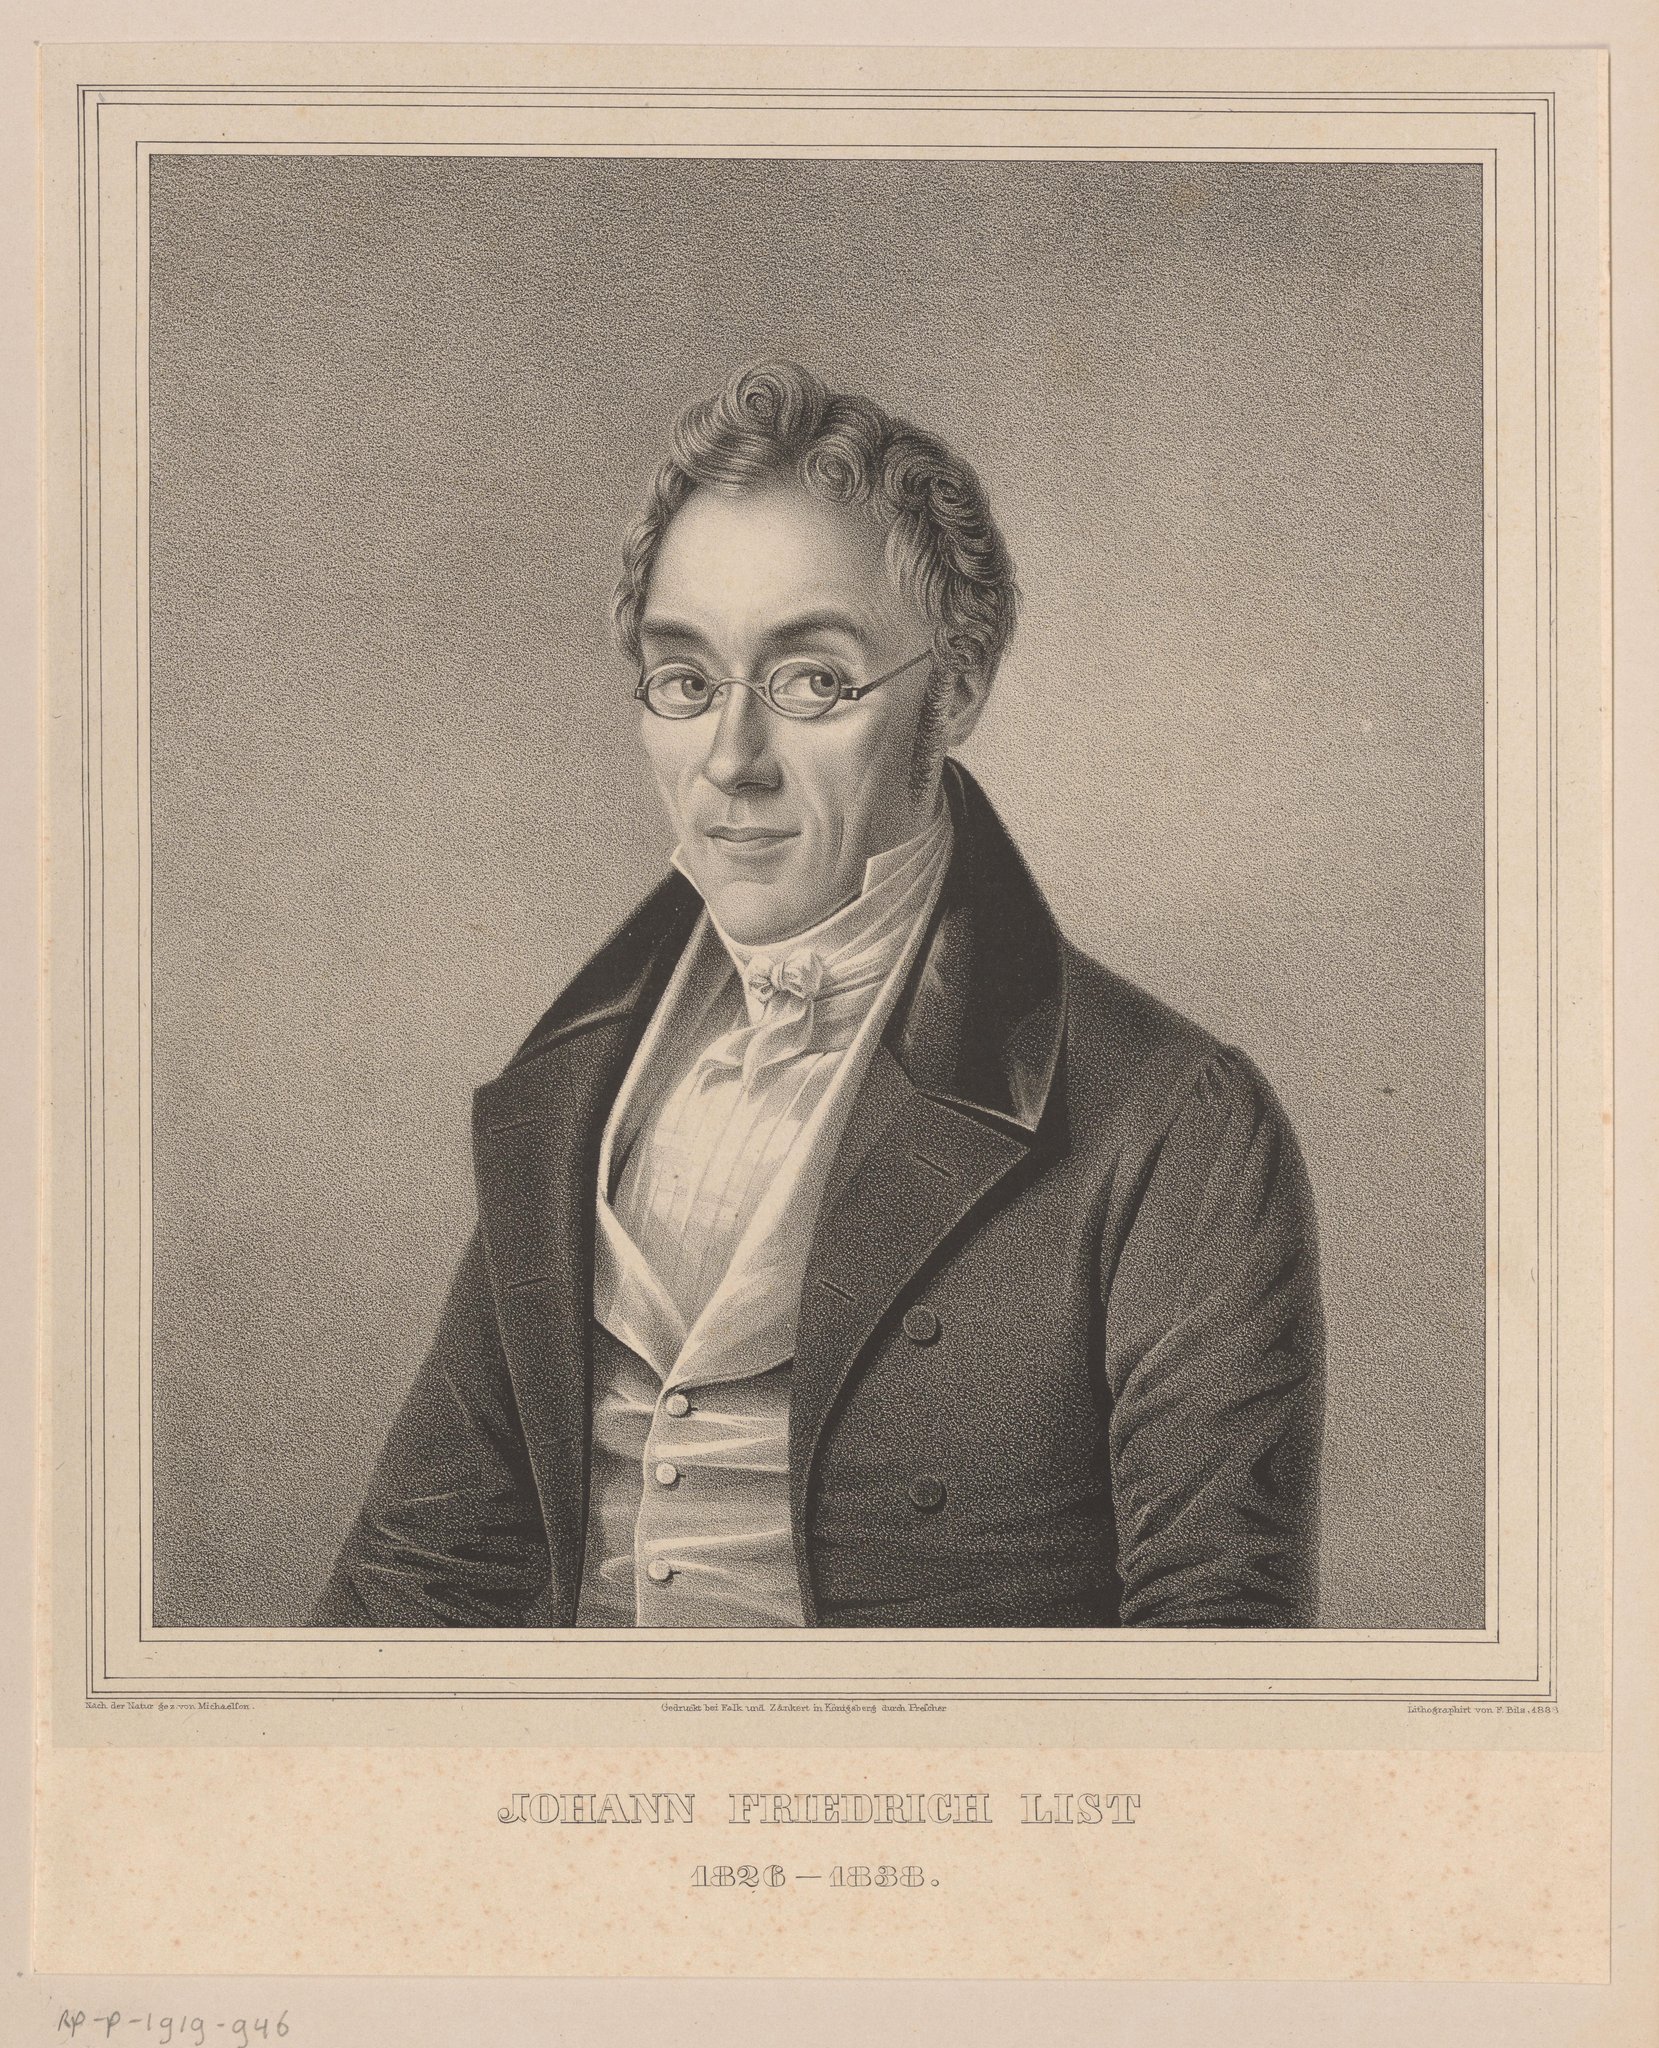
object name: print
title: Portret van Johann Friedrich List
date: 1838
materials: paper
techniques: lithograph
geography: königsberg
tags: mayor, burgomaster, historical persons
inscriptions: collector's mark: Lugt 2228